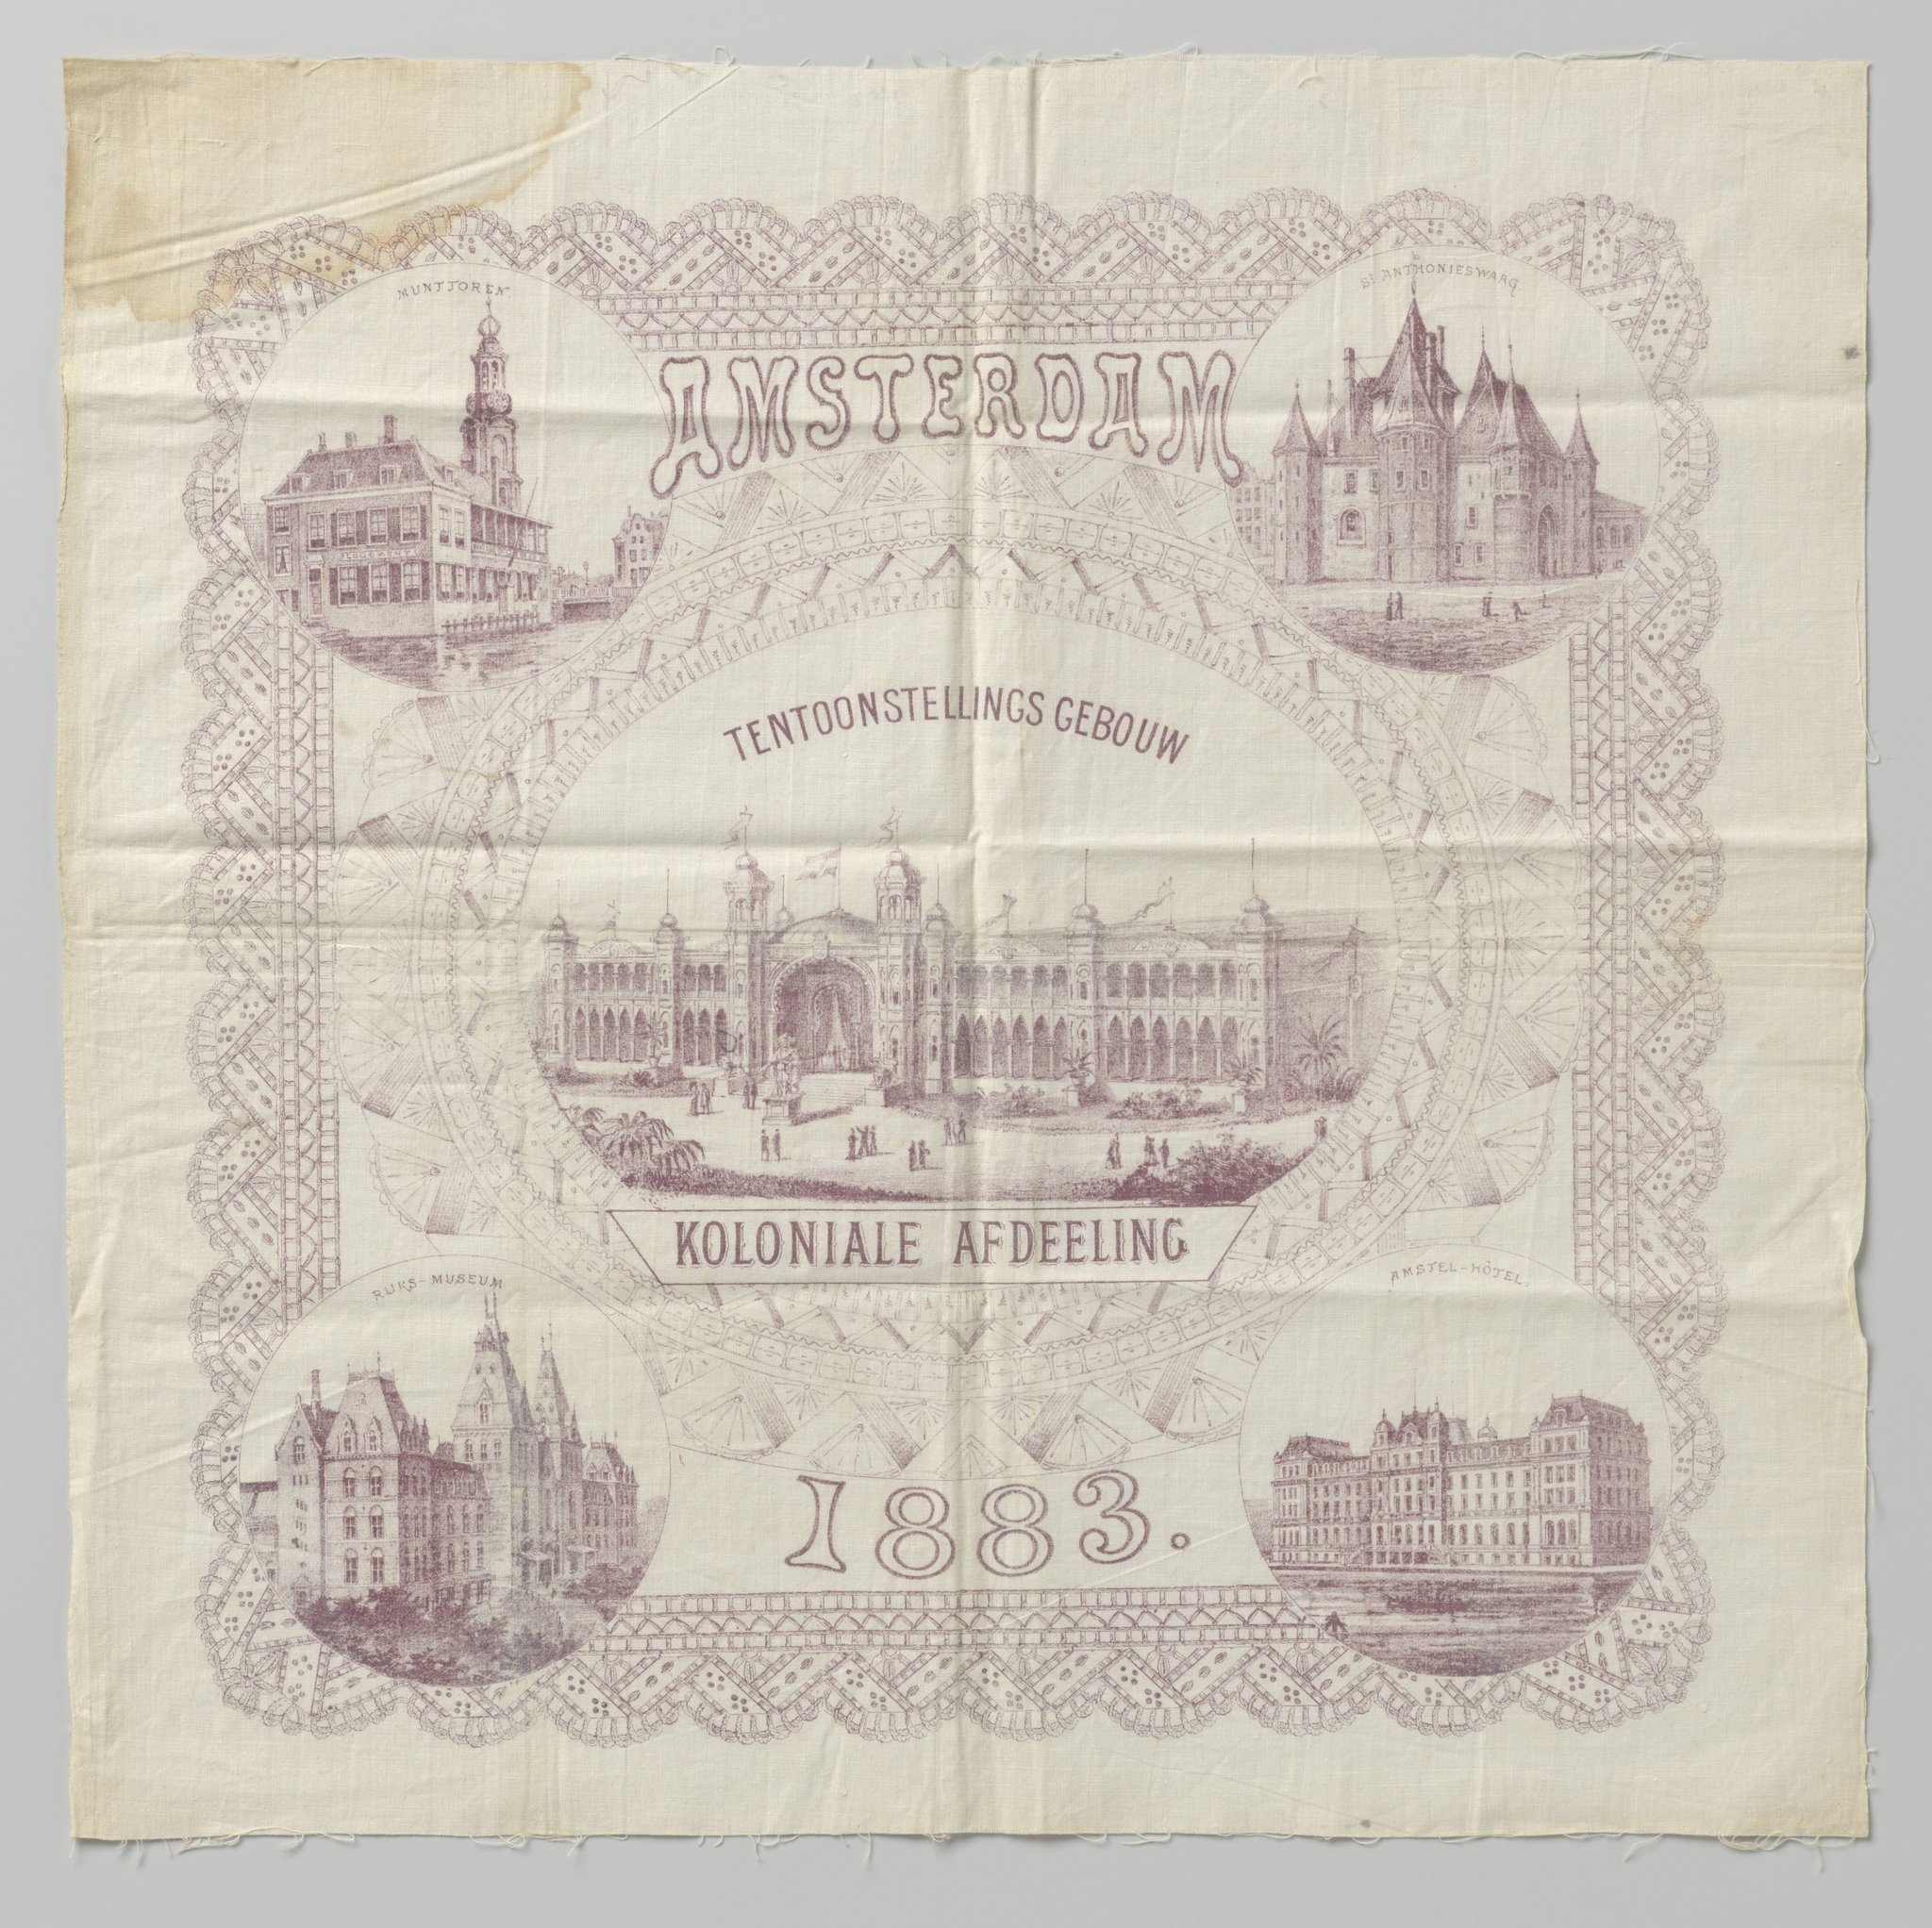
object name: cloth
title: Herinneringsdoek van de Koloniale tentoonstelling Amsterdam 1883, katoendruk in paars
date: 1883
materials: cotton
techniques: printing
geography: netherlands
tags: amsterdam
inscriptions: date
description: Herinneringsdoek van de Koloniale tentoonstelling Amsterdam, 1883, katoendruk in paars.